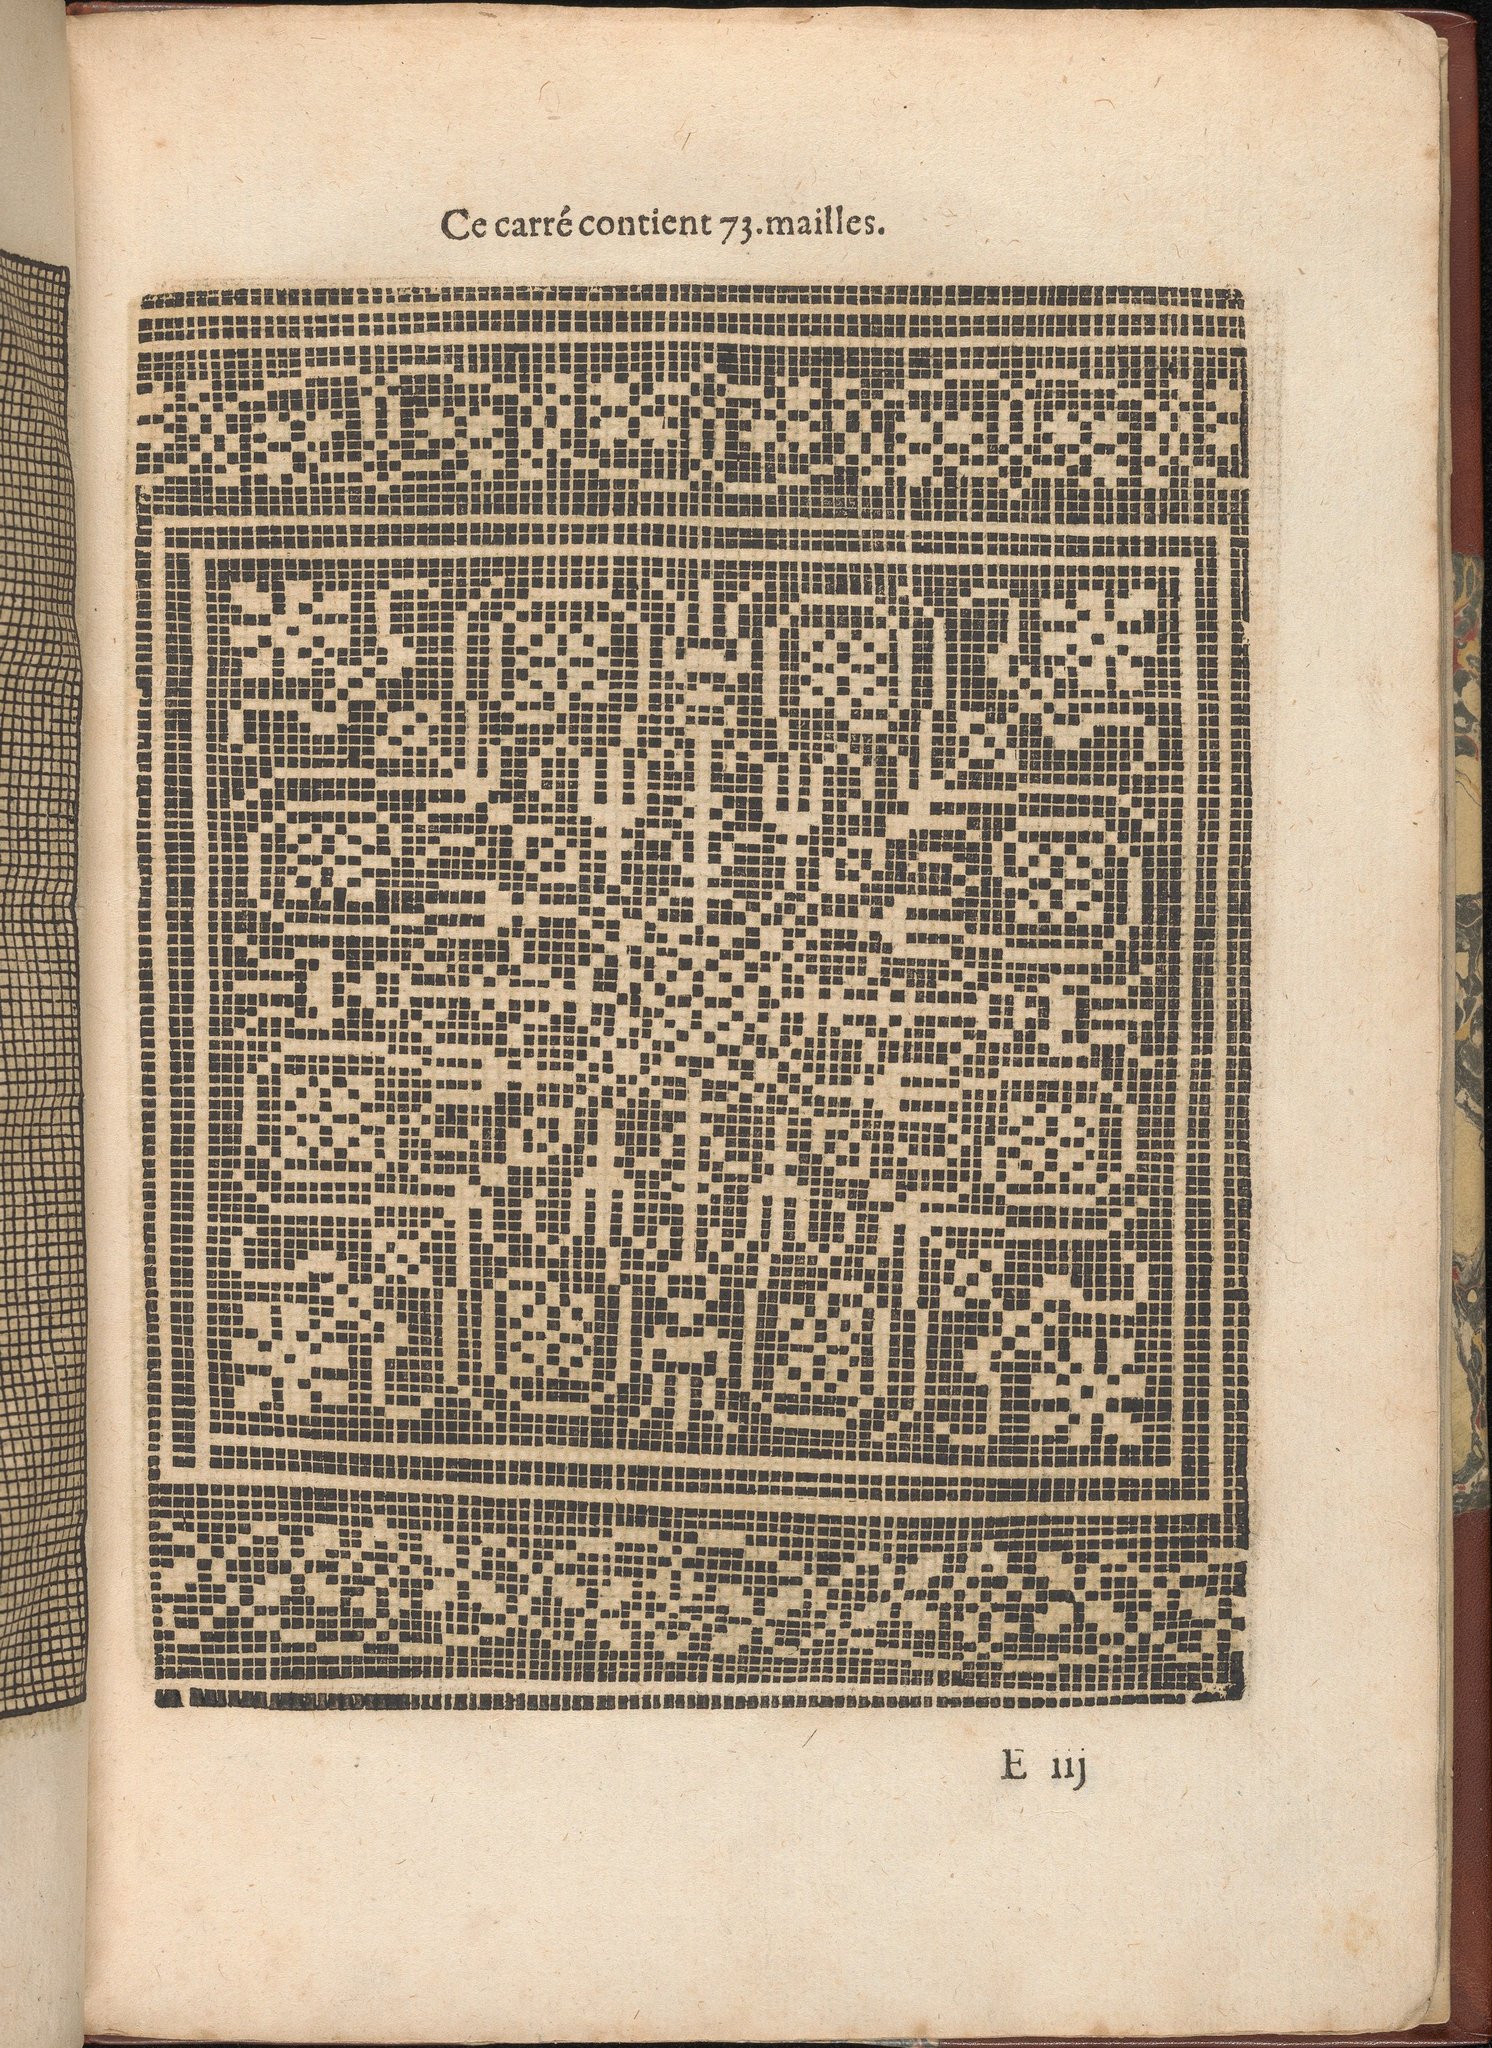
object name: book print ornament architecture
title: Les Secondes Oeuvres, et Subtiles Inventions De Lingerie du Seigneur Federic de Vinciolo Venitien, page 19 (recto)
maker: federico de vinciolo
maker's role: designer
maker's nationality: italian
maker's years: 1582-1599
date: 1603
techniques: woodcut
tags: ornament